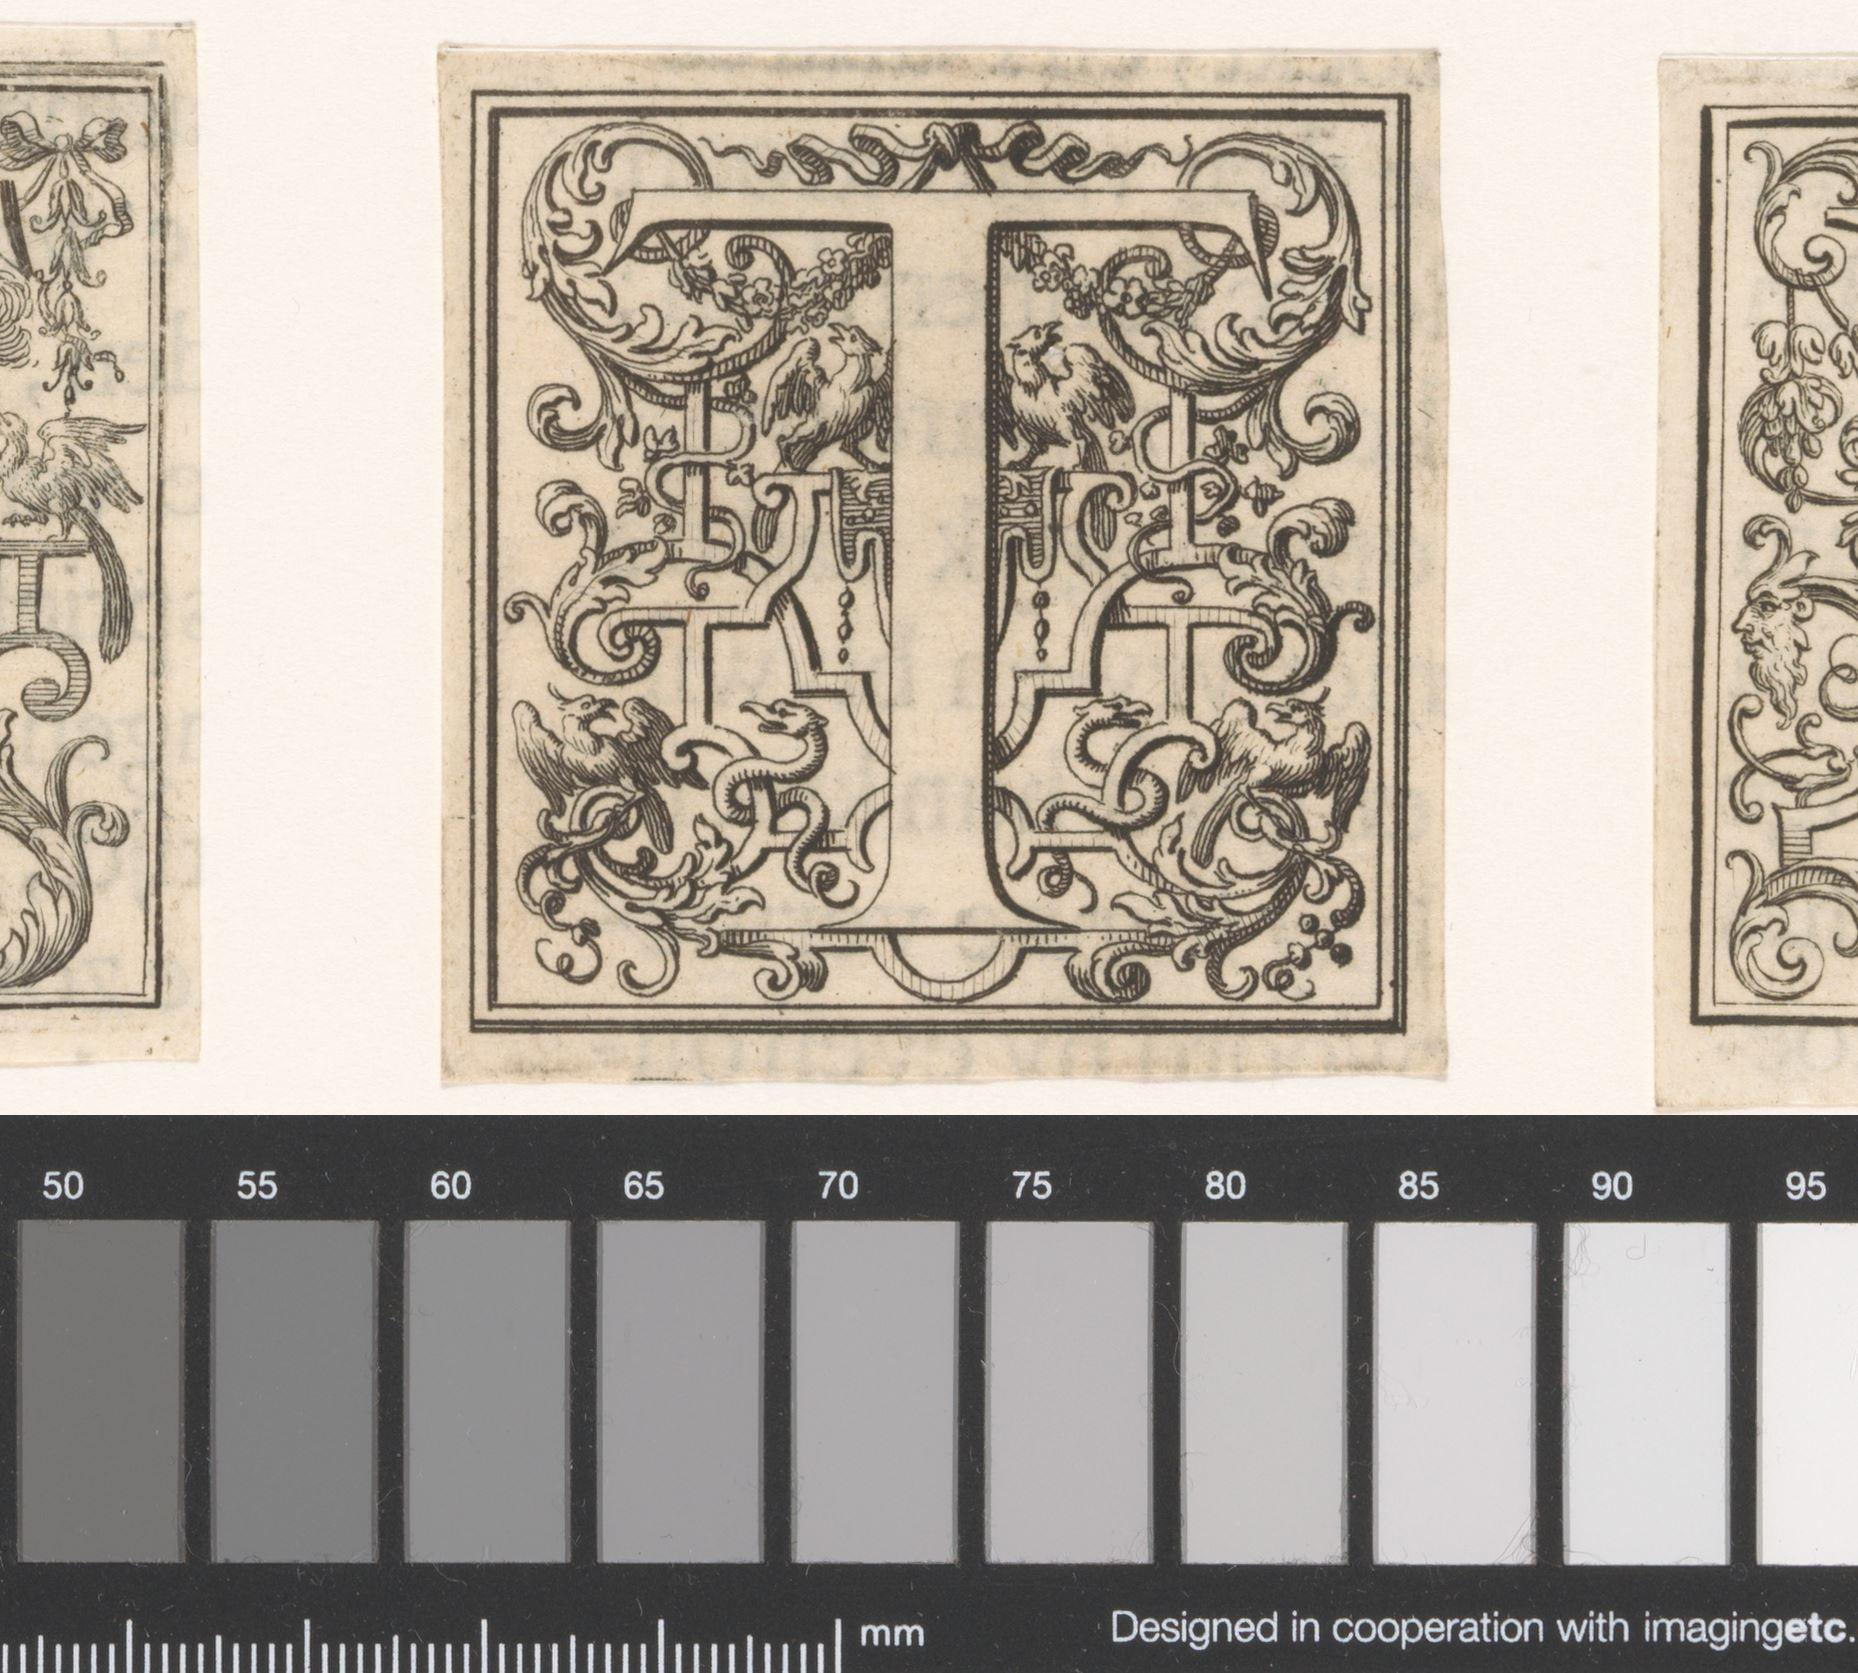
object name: ornament print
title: Letter T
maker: Anonymous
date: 1700-1799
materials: paper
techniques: etching, letterpress printing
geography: netherlands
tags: fancy letters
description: Letter T tegen een achtergrond met vlechtwerk en vogels.